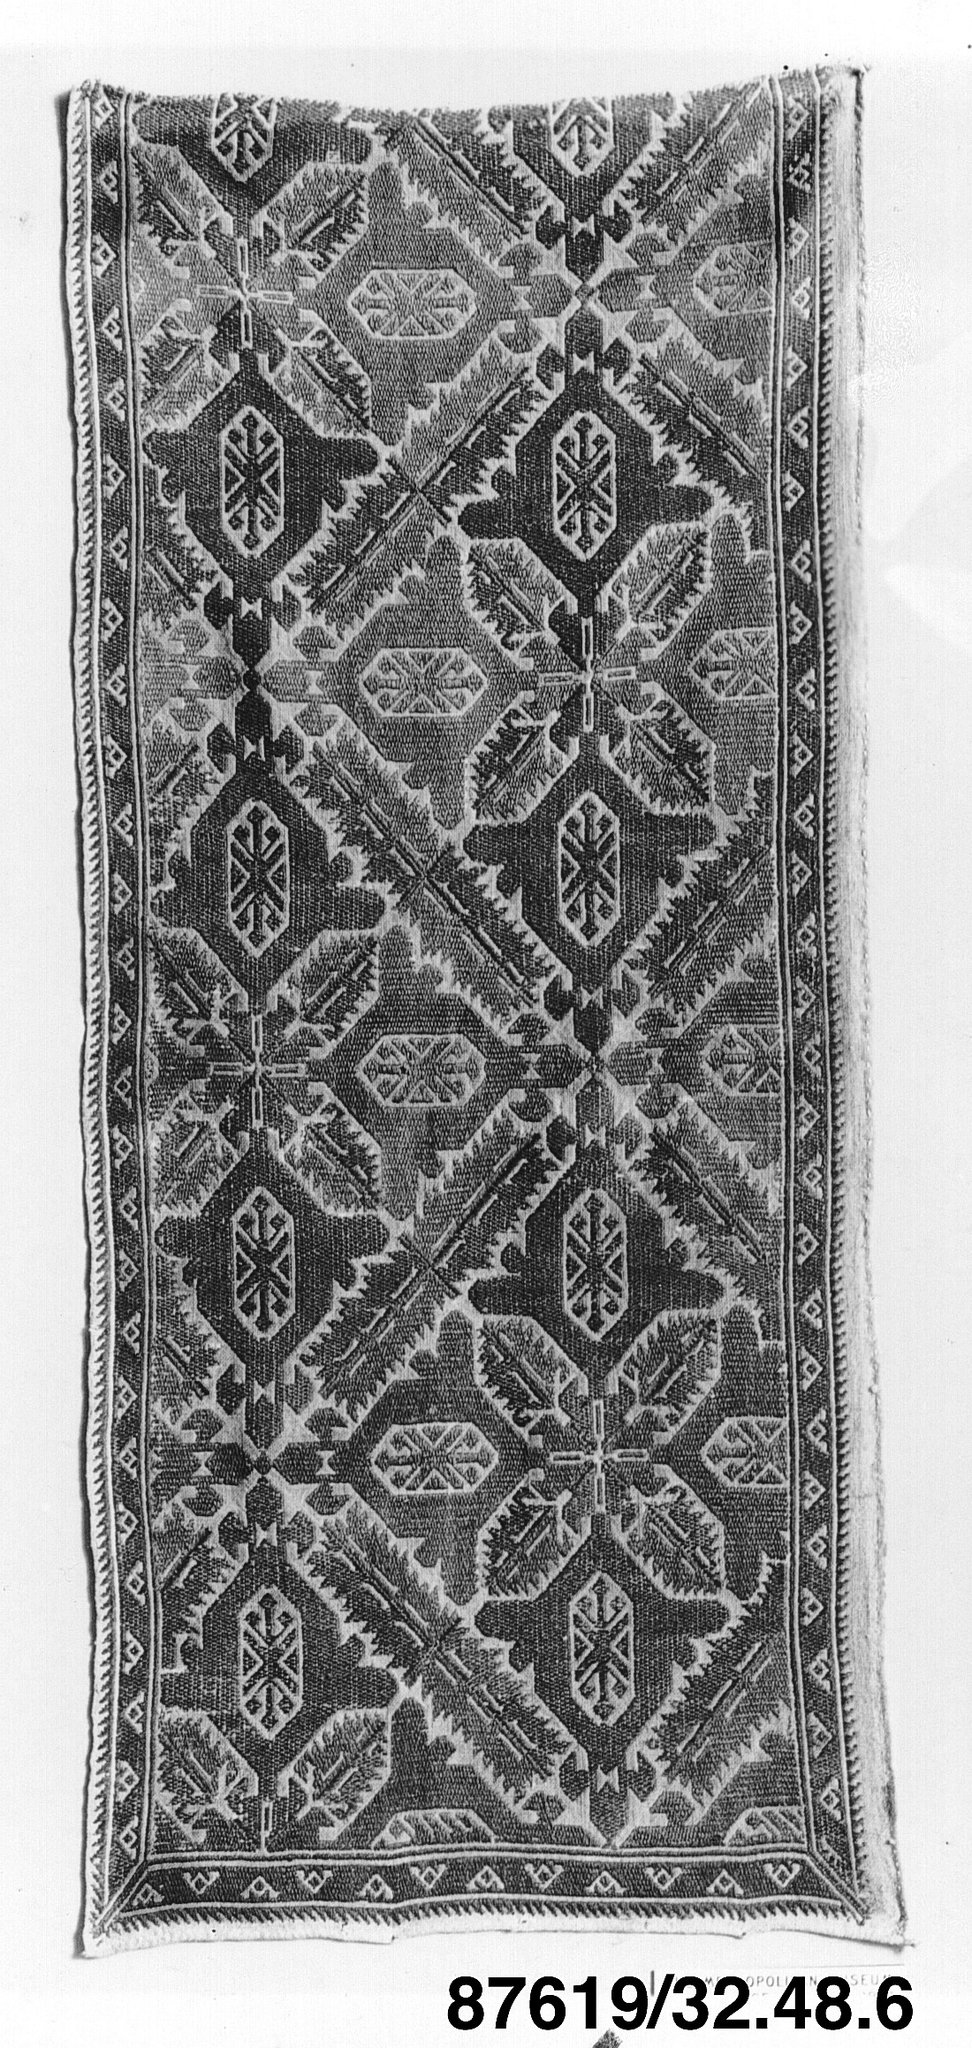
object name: panel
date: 1701-1800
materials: linen, silk